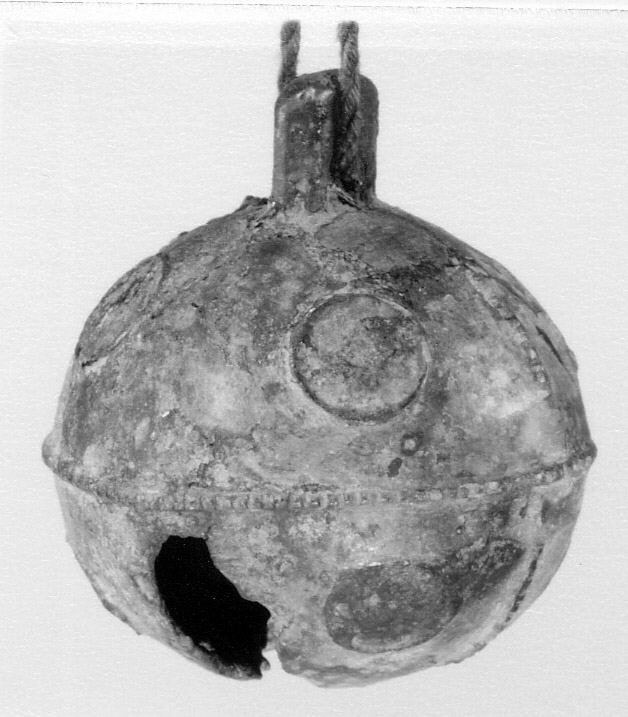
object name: horse bell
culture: japanese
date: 200-538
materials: bronze